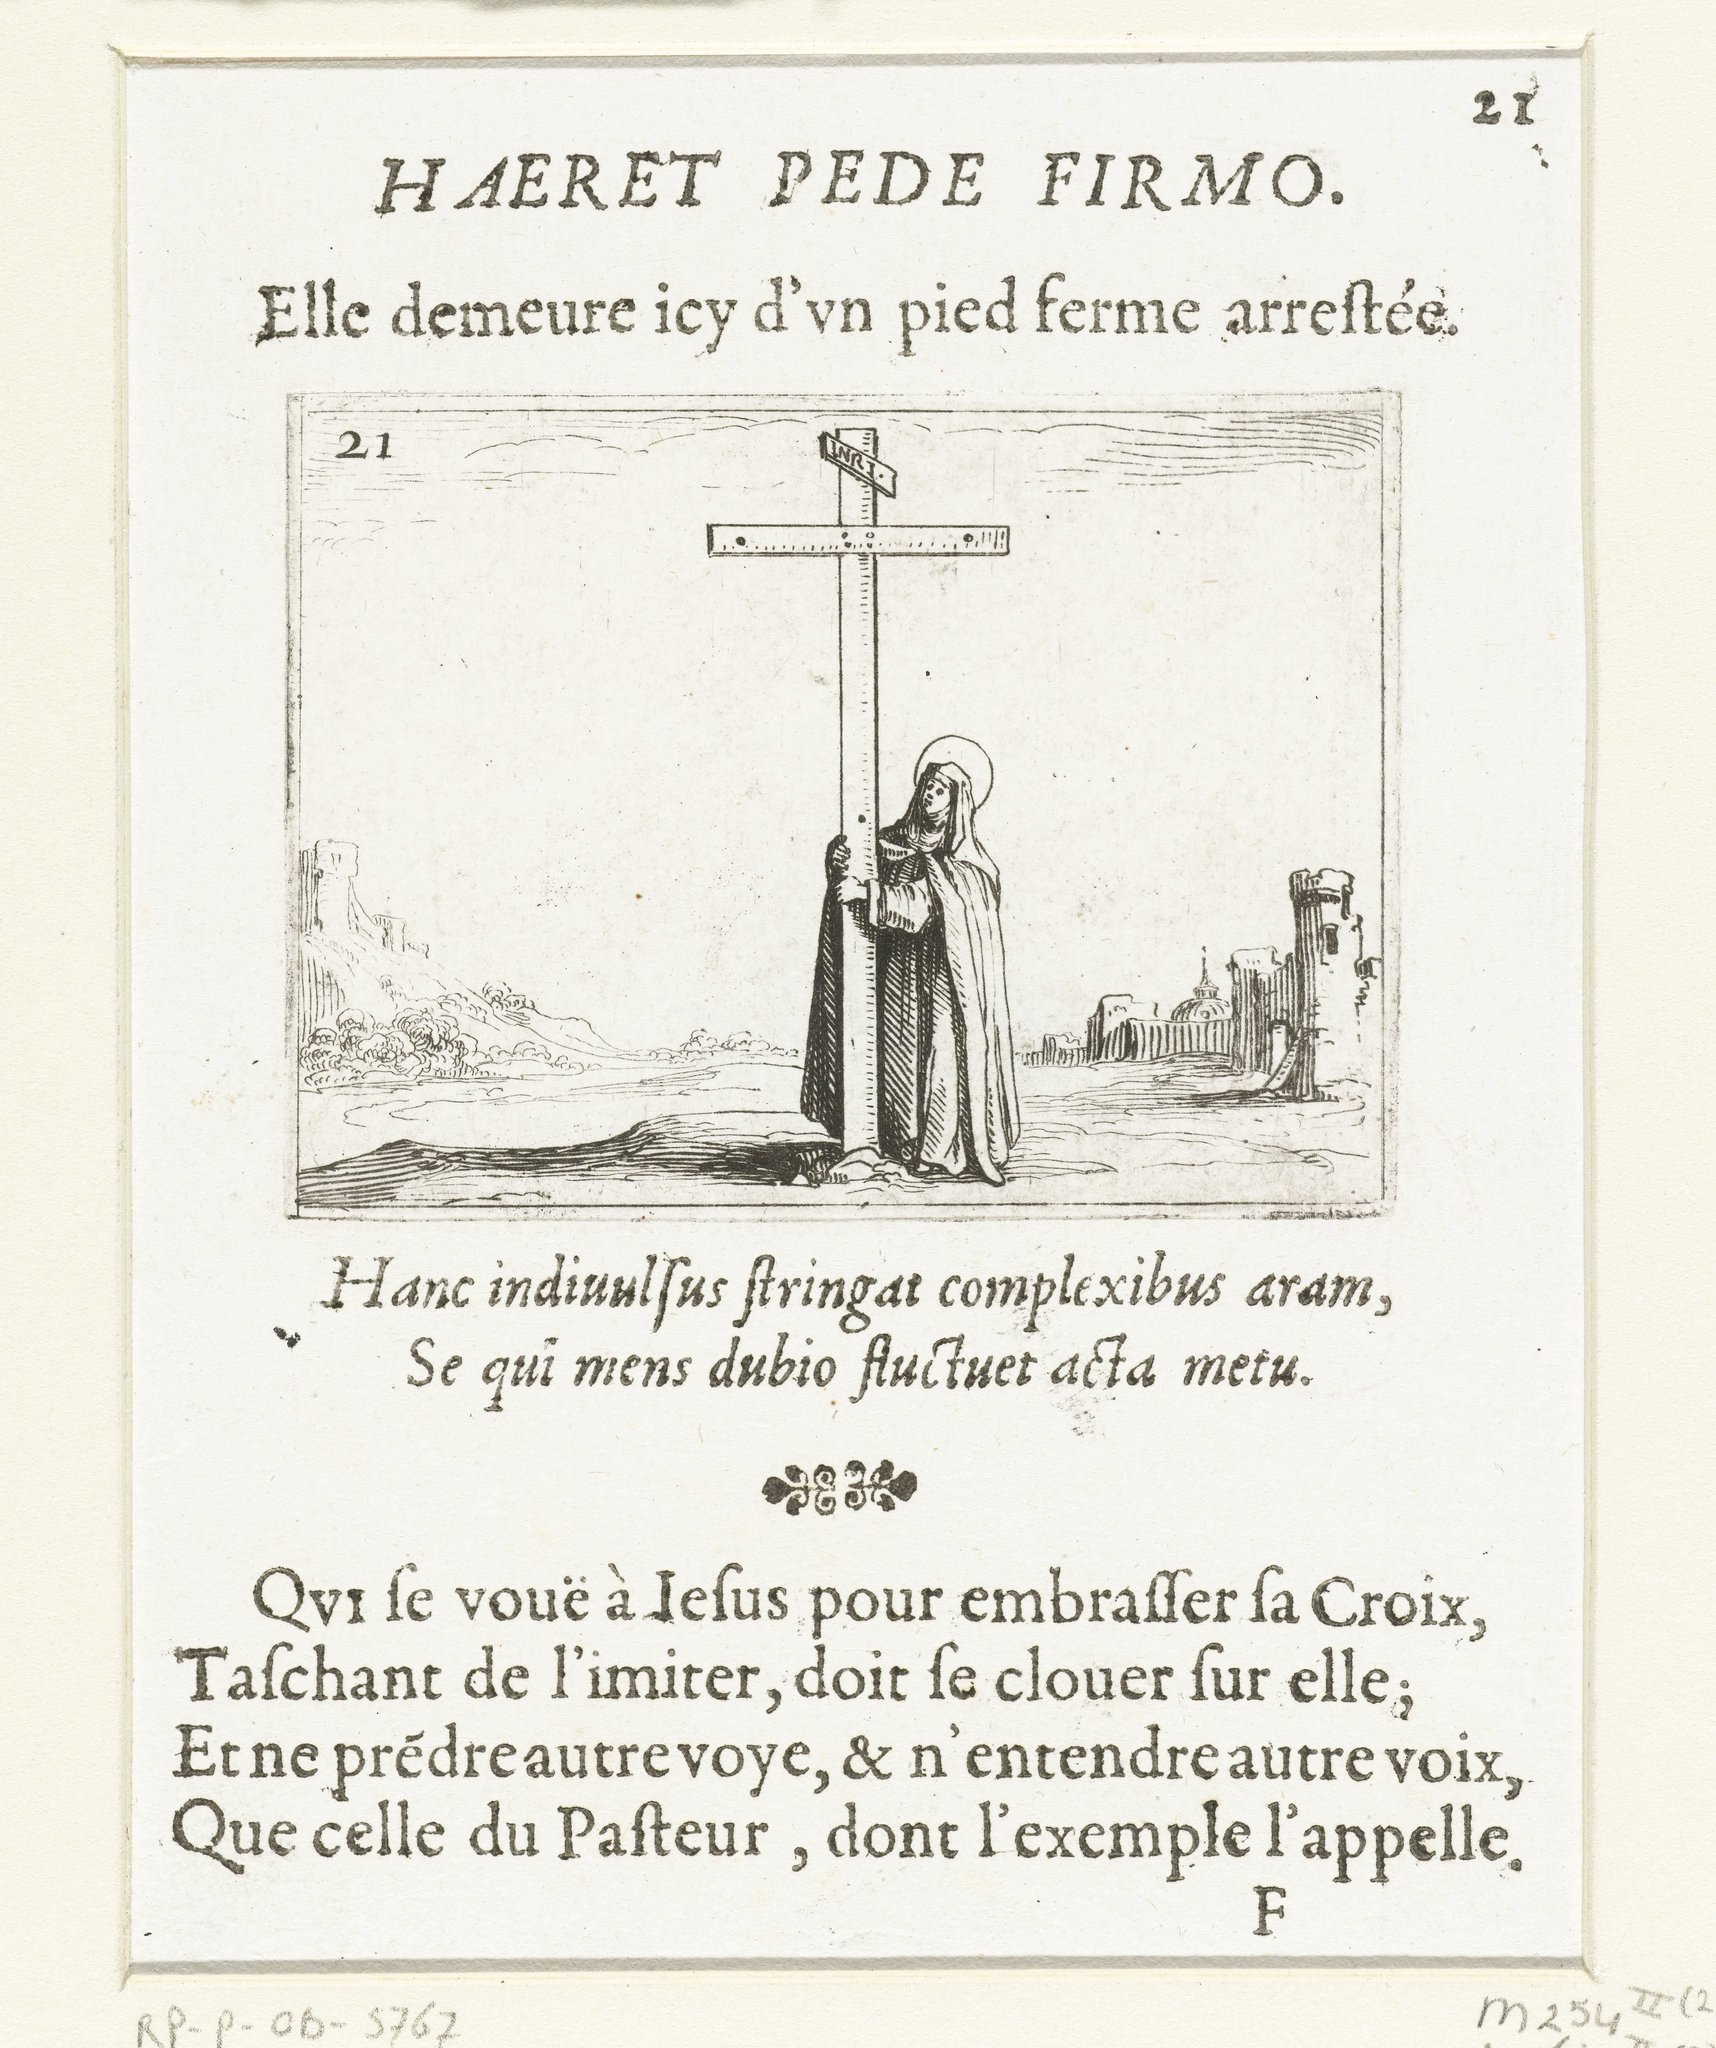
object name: print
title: Kloosterleven in emblemen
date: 1621-1635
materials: paper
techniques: etching, letterpress printing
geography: paris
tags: the empty cross(es), female saints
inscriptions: collector's mark: Lugt 240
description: Voorstelling van een vrouwelijke heilige die het kruis waaraan Christus stierf omarmt. Boven en onder deze prent Latijnse en Franse teksten in boekdruk. Dit blad is onderdeel van de embleemserie 'Kloosterleven in emblemen'. De tweede staat van deze serie behelst naast een geïllustreerde titelpagina en 26 emblemen nog een titelpagina en een blad met opdracht, beide in boekdruk zonder afbeelding.